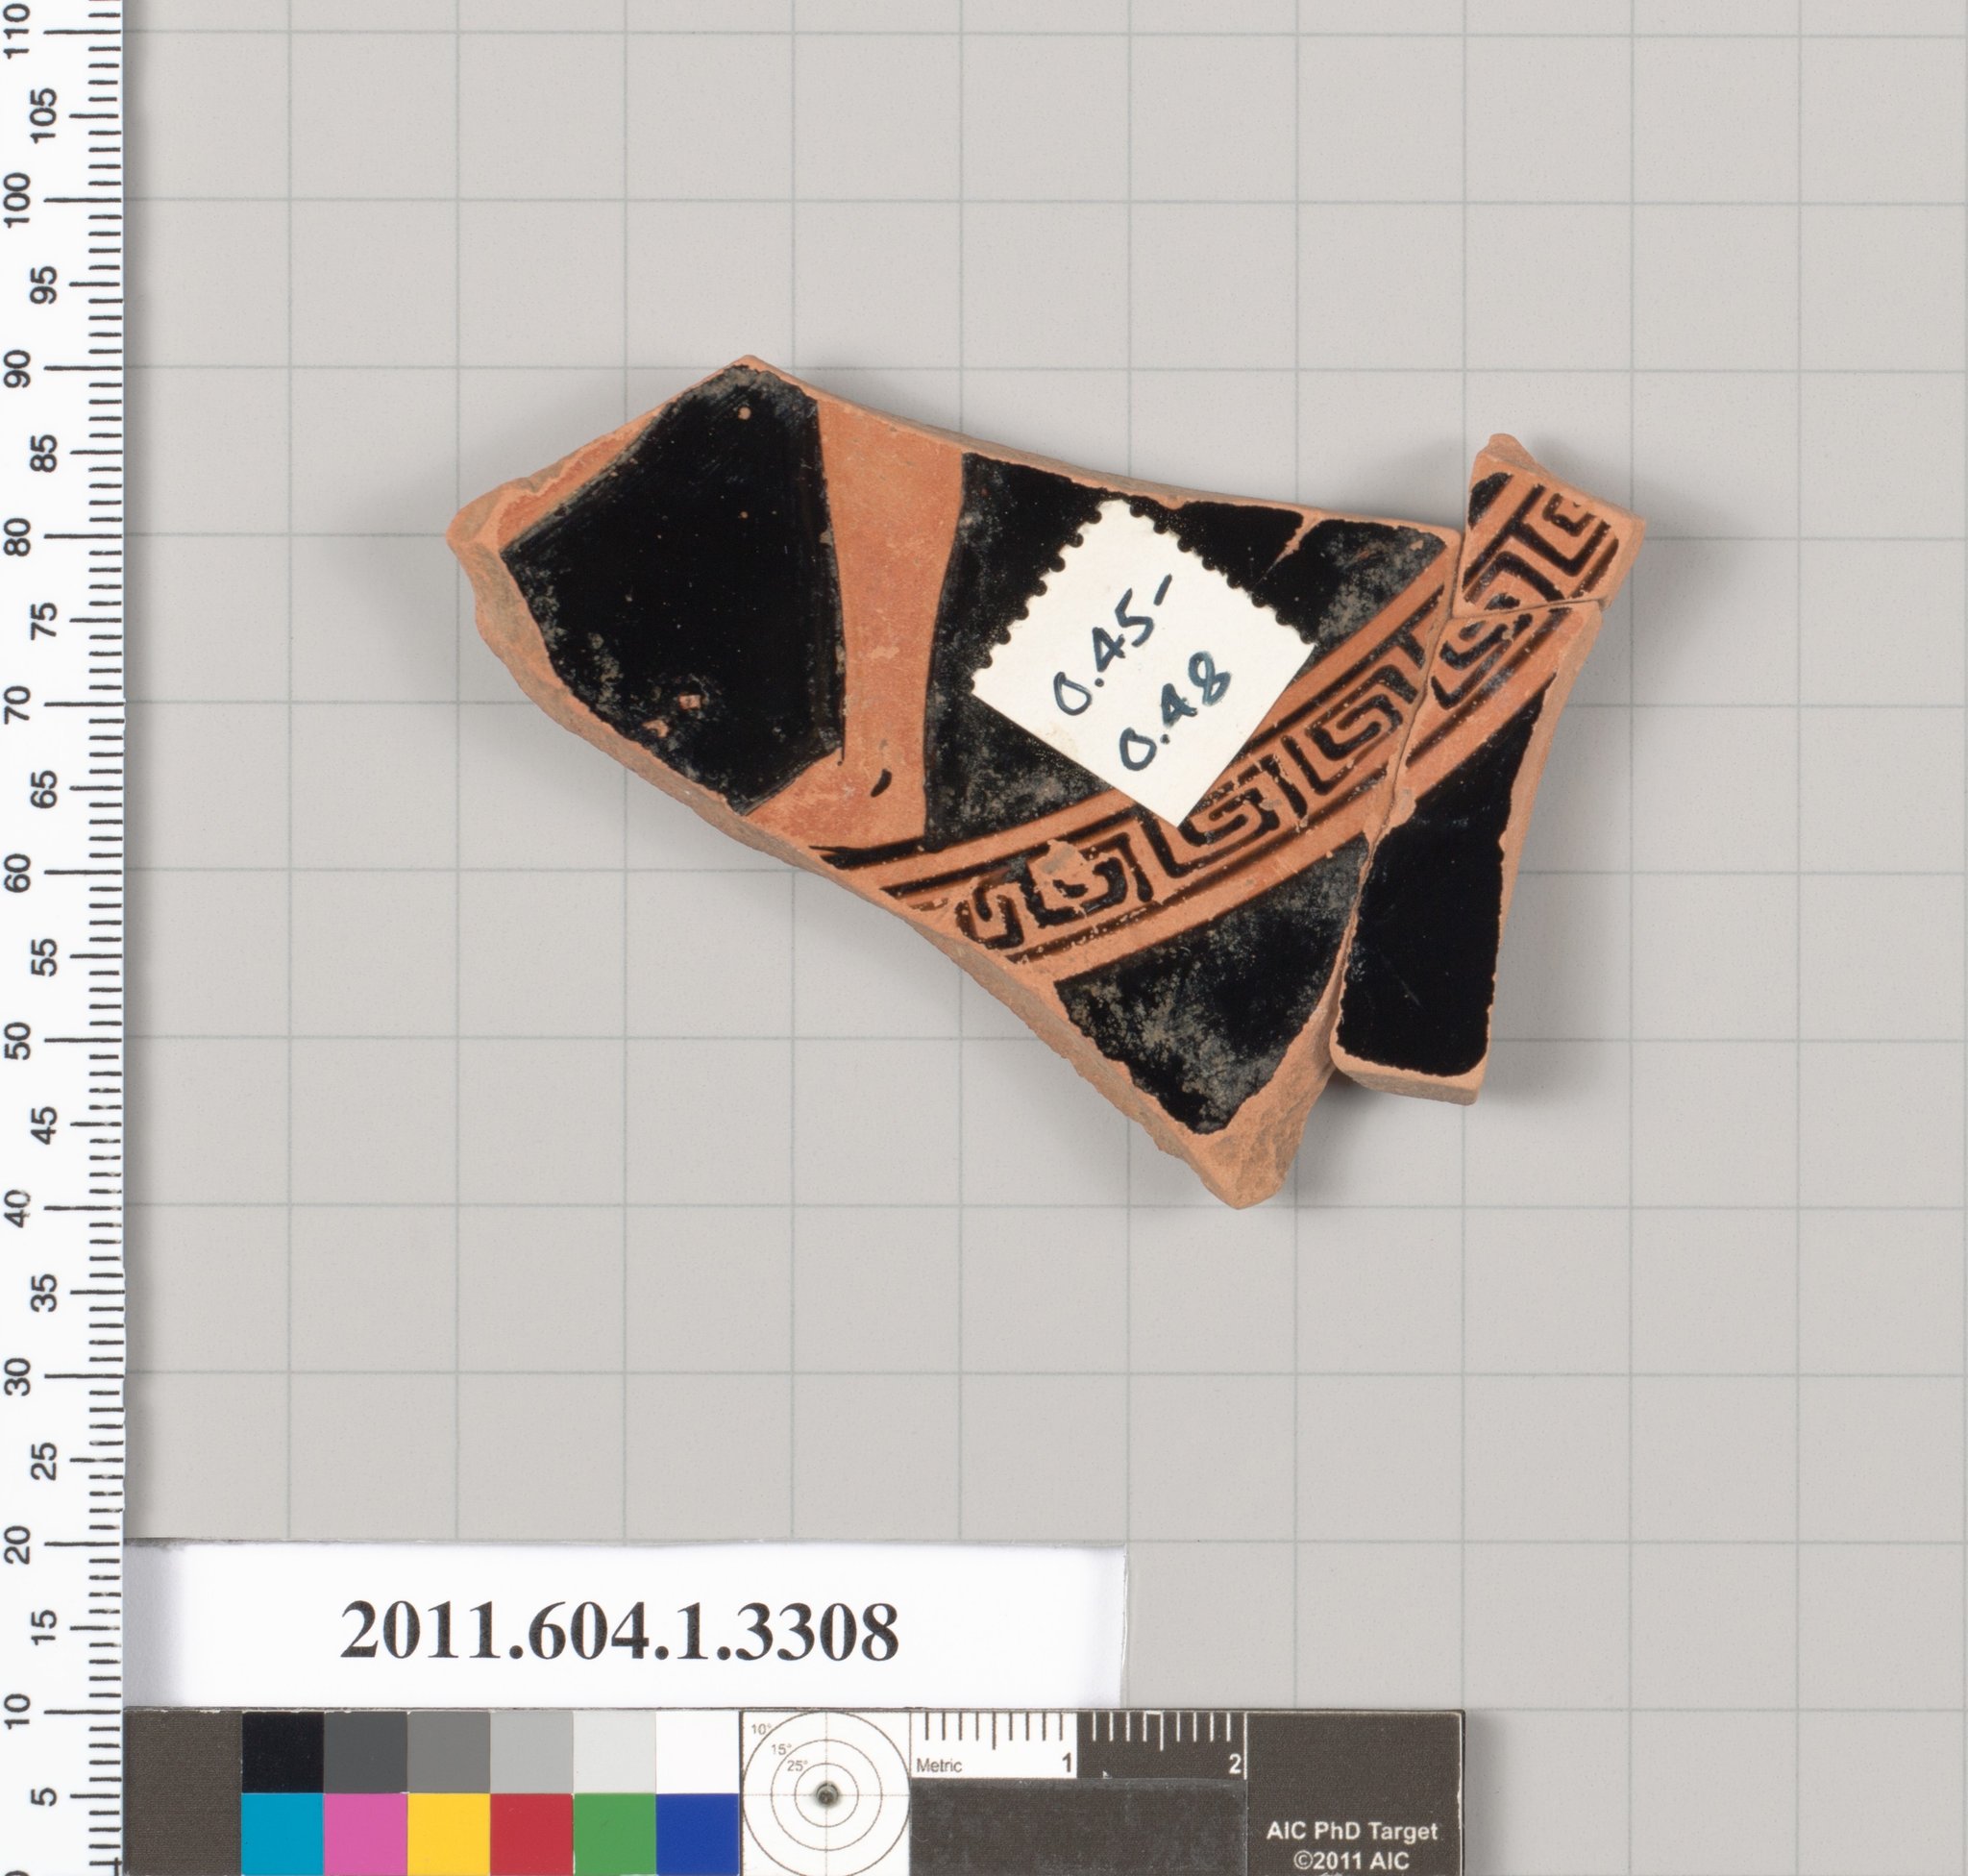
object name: kylix fragment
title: Terracotta fragment of a kylix (drinking cup)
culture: greek, attic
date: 490-470 BCE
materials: terracotta